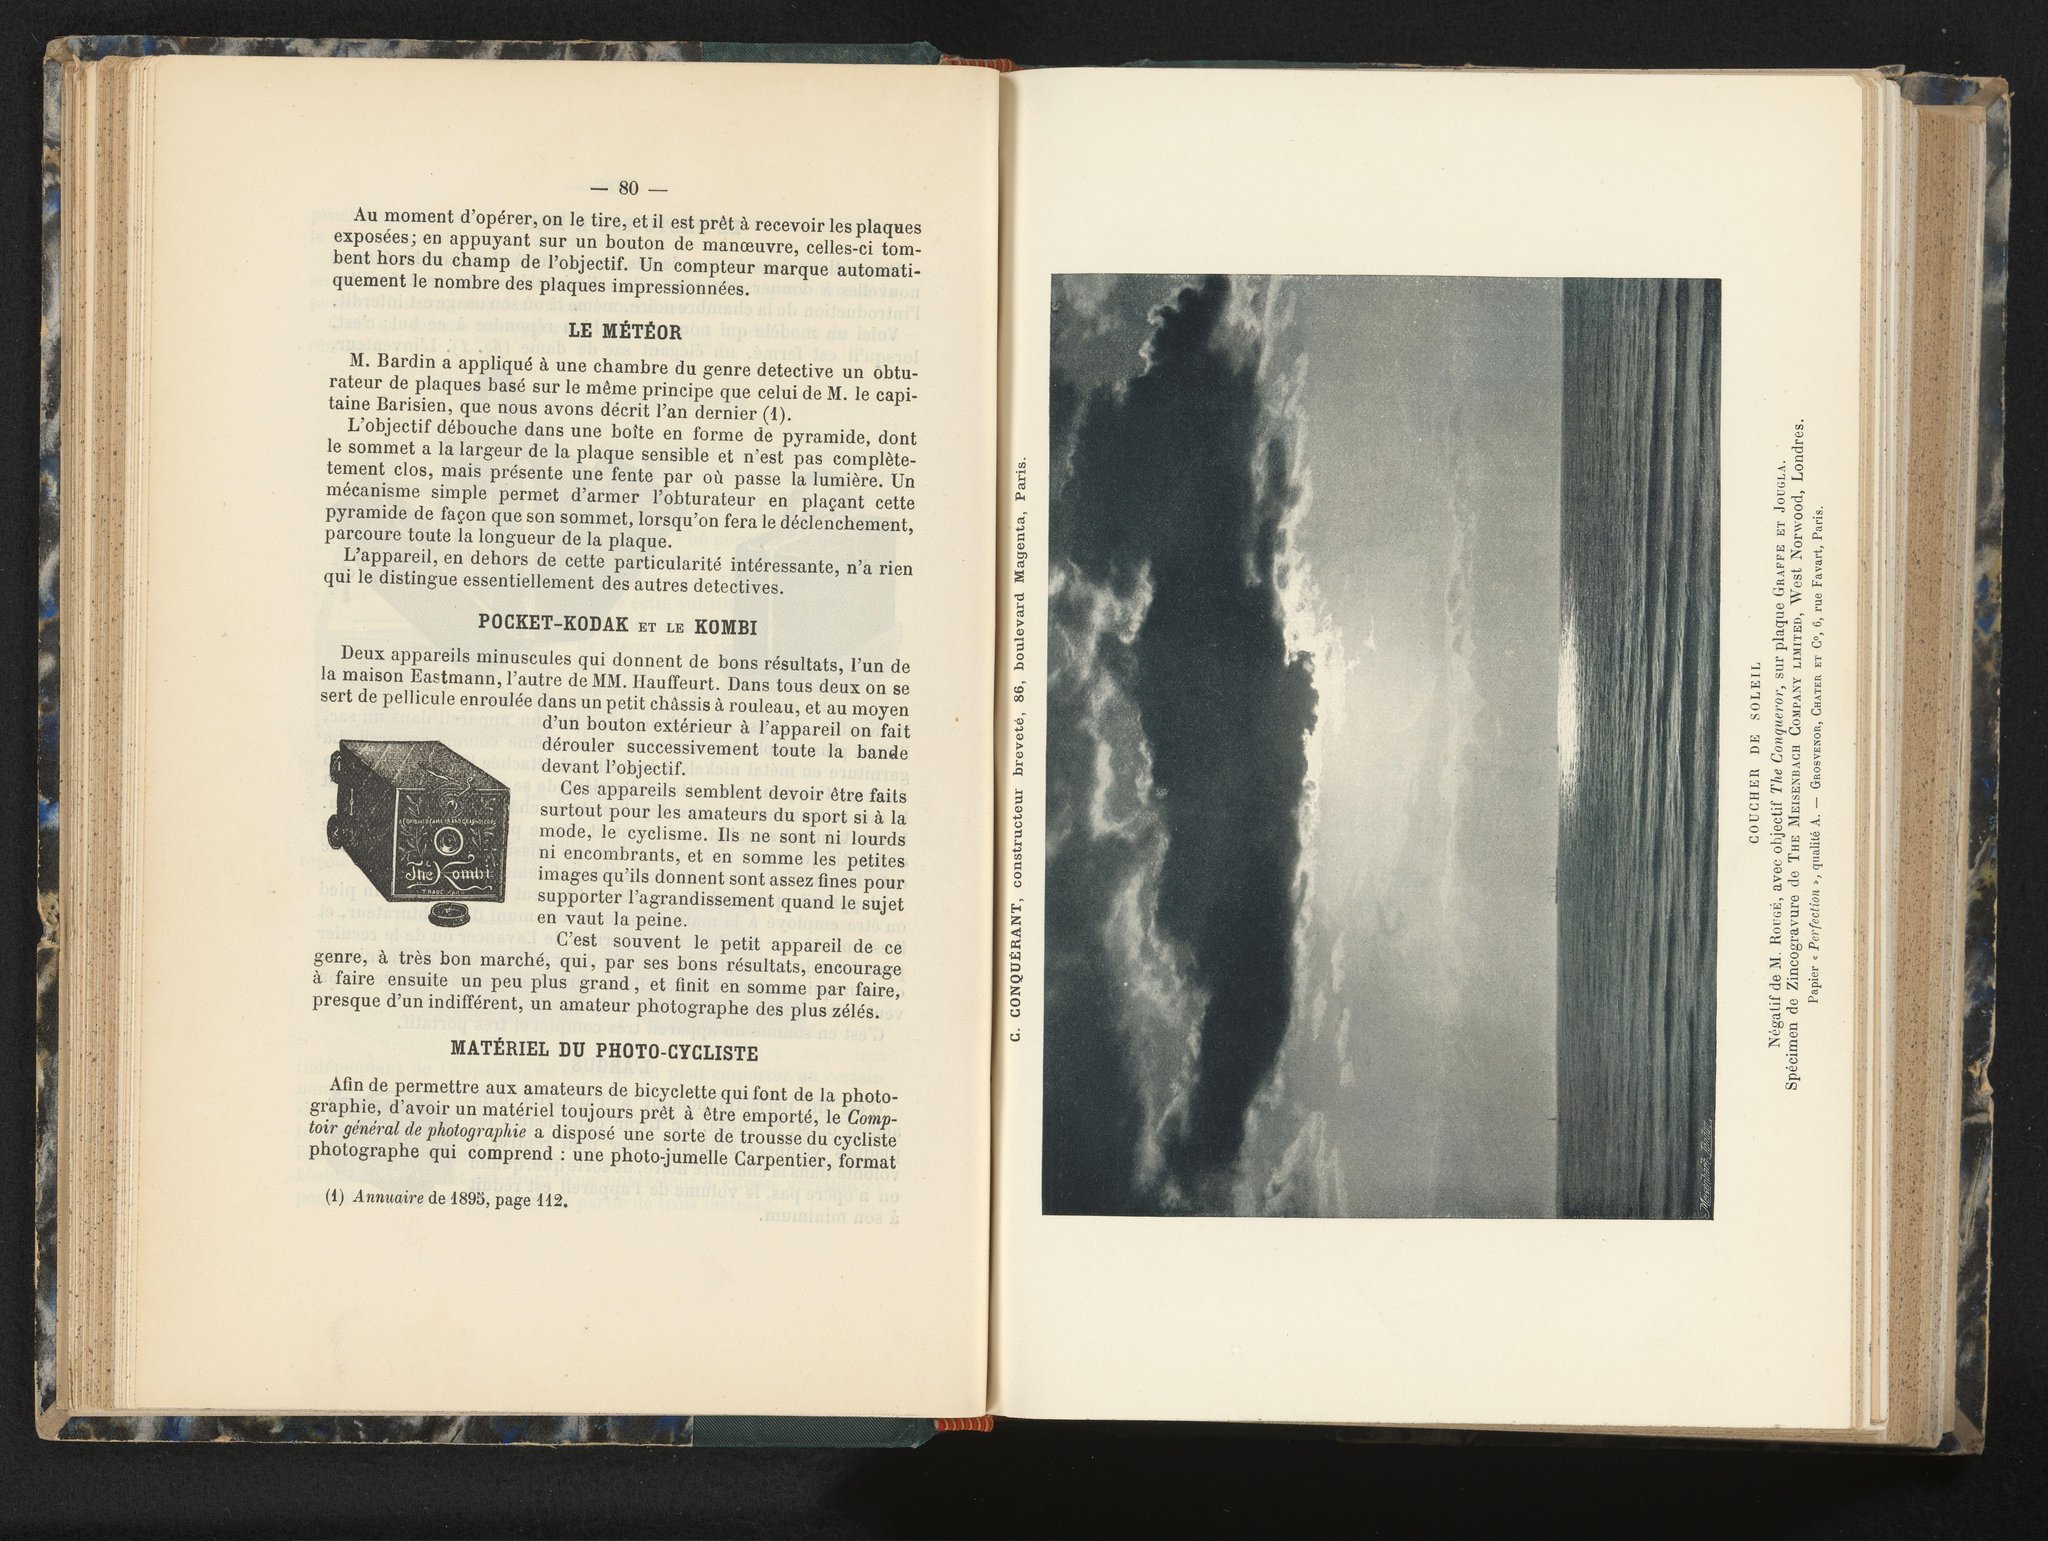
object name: page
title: Zonsondergang boven zee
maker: rougé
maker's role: fotograaf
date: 1891-1896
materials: paper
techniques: autotype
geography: london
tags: sunset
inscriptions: inscription: ‘Négatif de M. Rougé, avec objectiv The Conqueror, sur plaque Graffe et Jougla./ Spécimen de Zincogravure de The Meisenbach Company Limited, West Norwood, Londres./ Papier < Perfection >, qualité A. - Grosvenor, Chater et Co, 6, rue Favart, Paris.’, address: ‘C. CONQUÉRANT, constructeur breveté, 86, boulevard Magenta, Paris.’